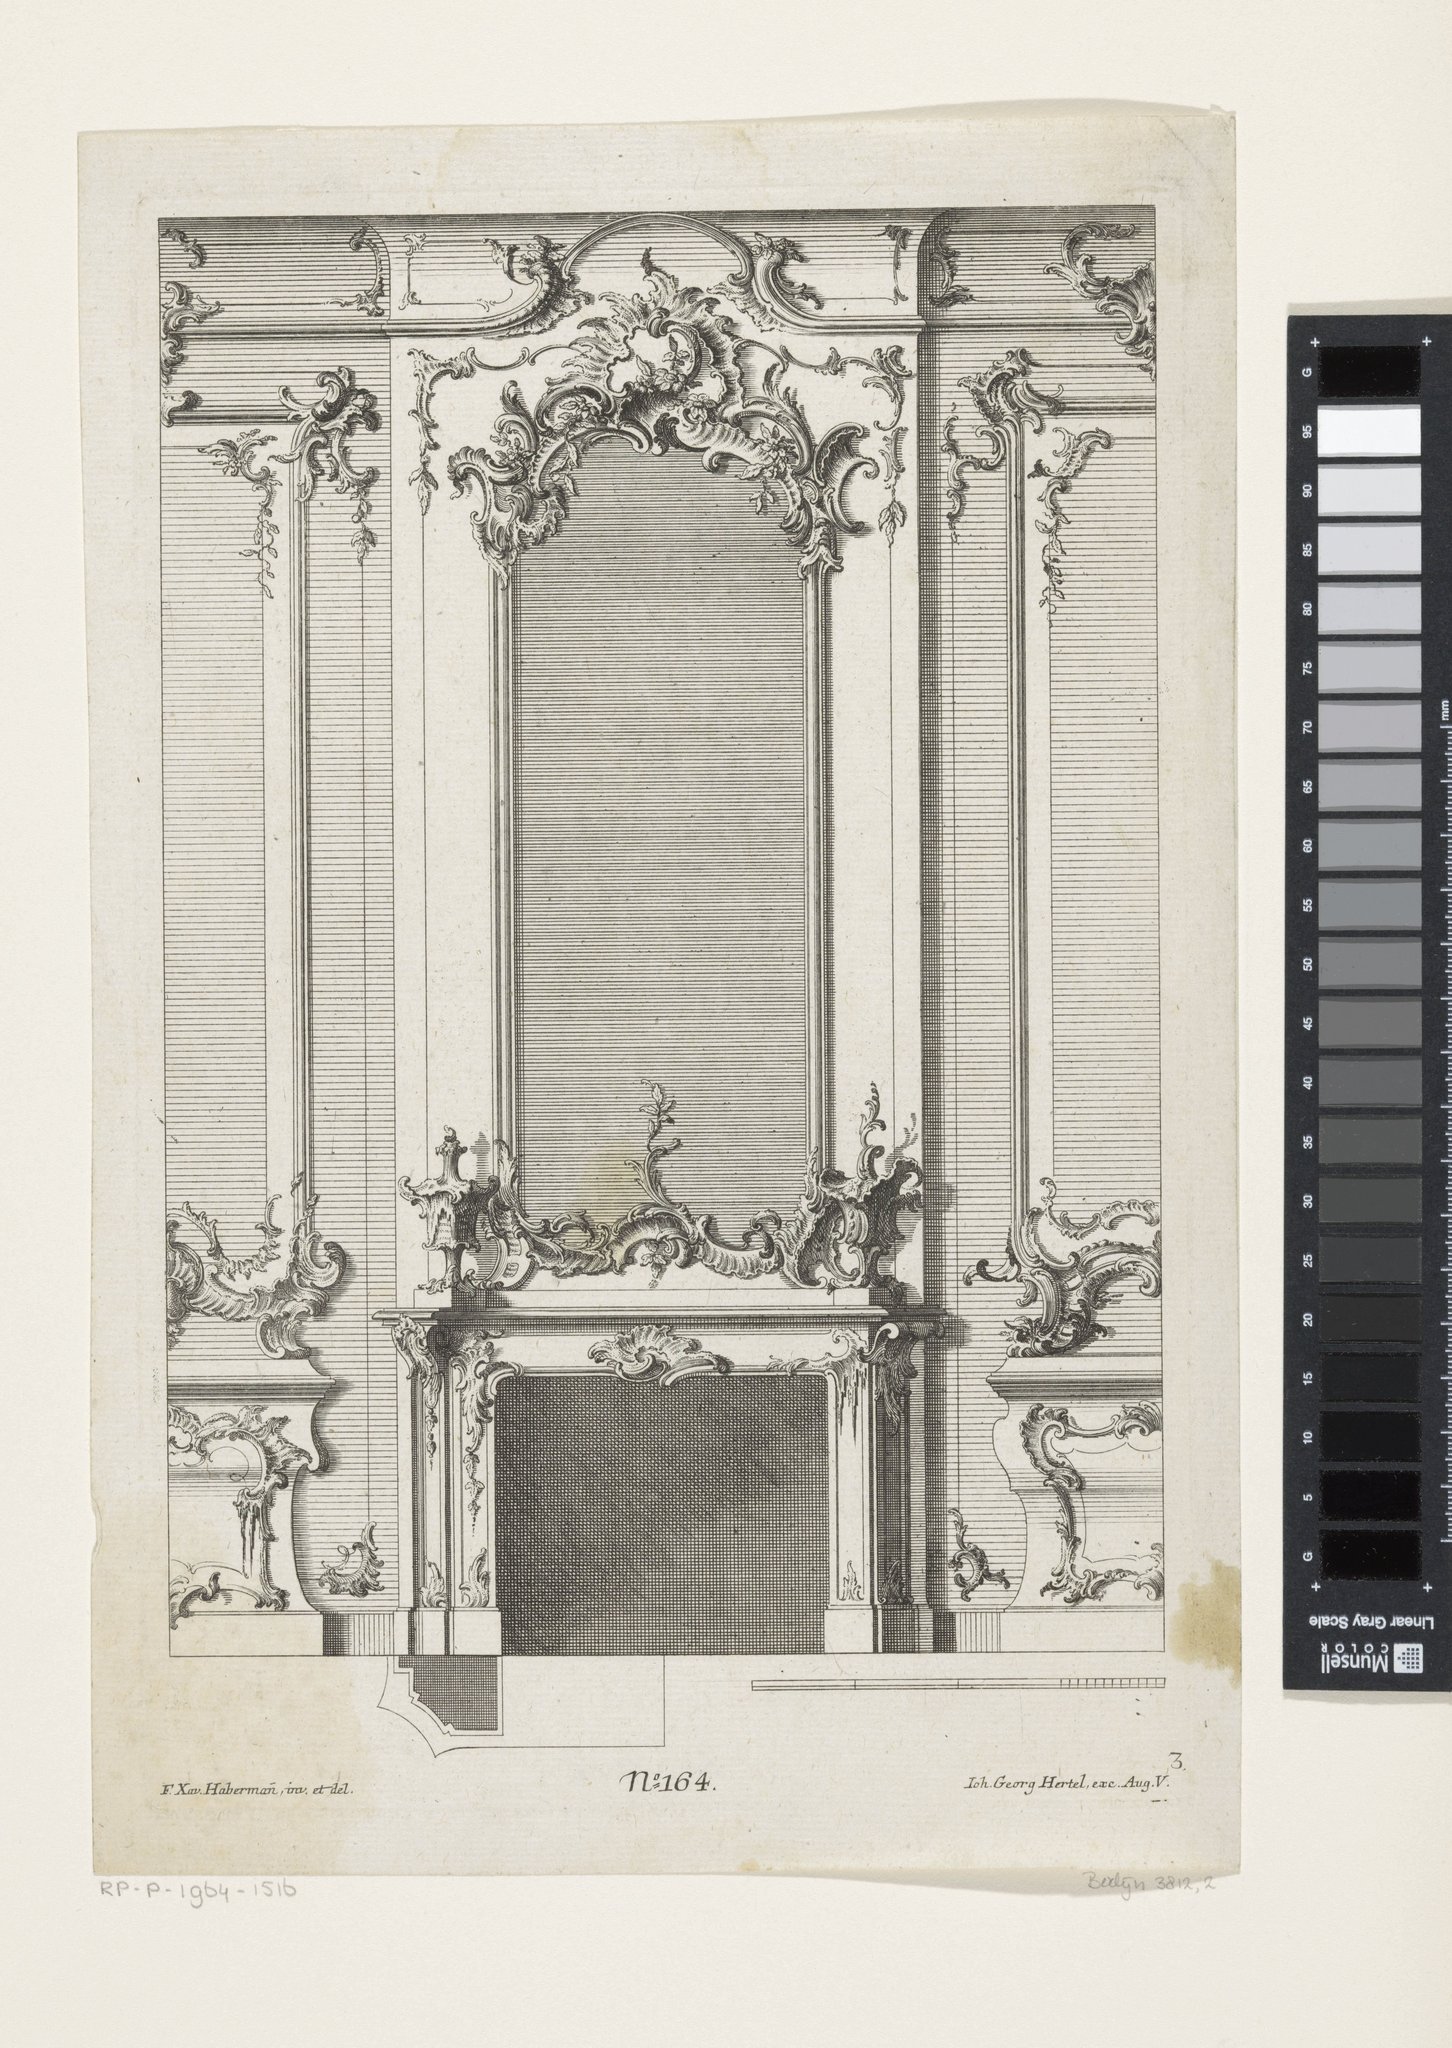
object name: ornament print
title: Schouw met vazen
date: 1731-1775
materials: paper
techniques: engraving, etching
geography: augsburg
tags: vase ~ ornament, open hearth, fire-place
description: Schouw met rocaille ornamenten en twee vazen. Uitgeversnummer 164.